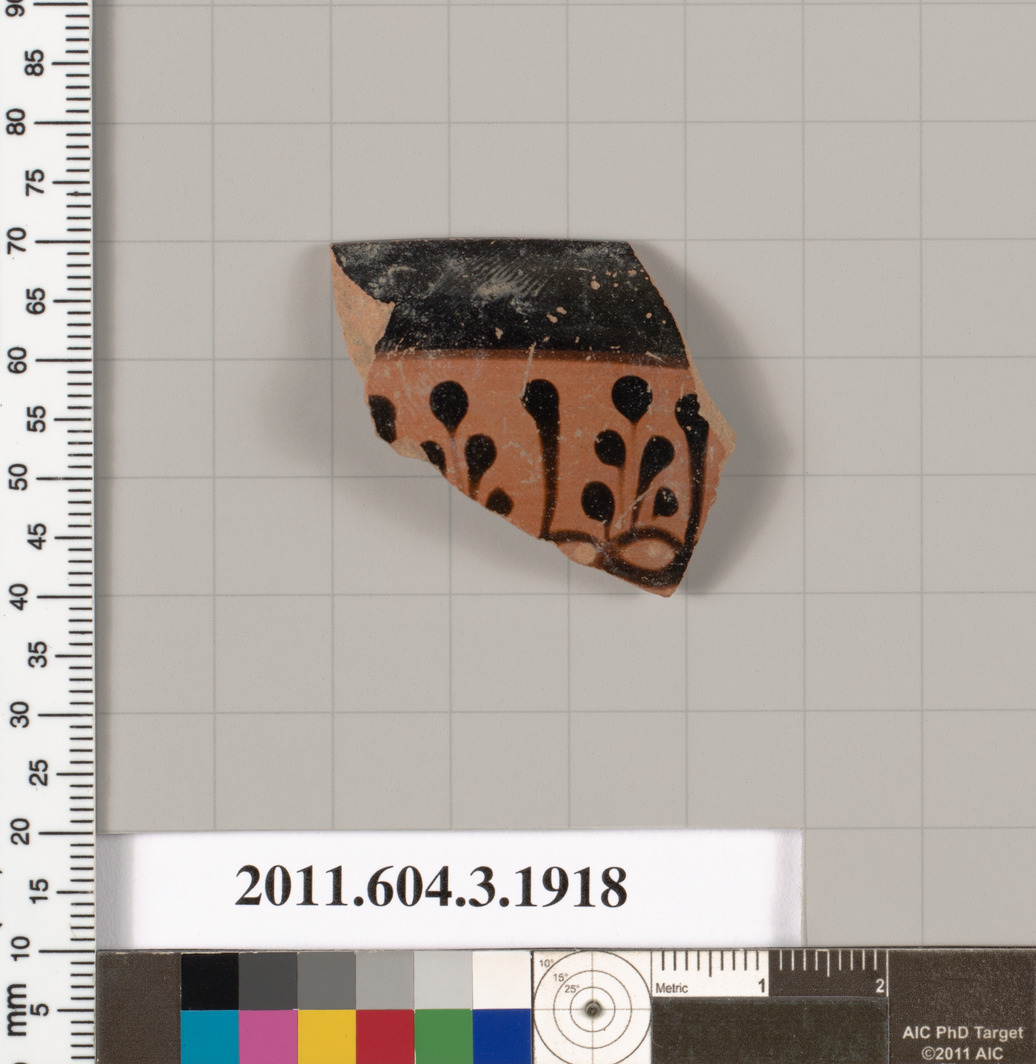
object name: kylix or skyphos fragment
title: Terracotta fragment of a kylix (drinking cup) or a skyphos (deep drinking cup)?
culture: greek, attic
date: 534-468 BCE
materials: terracotta